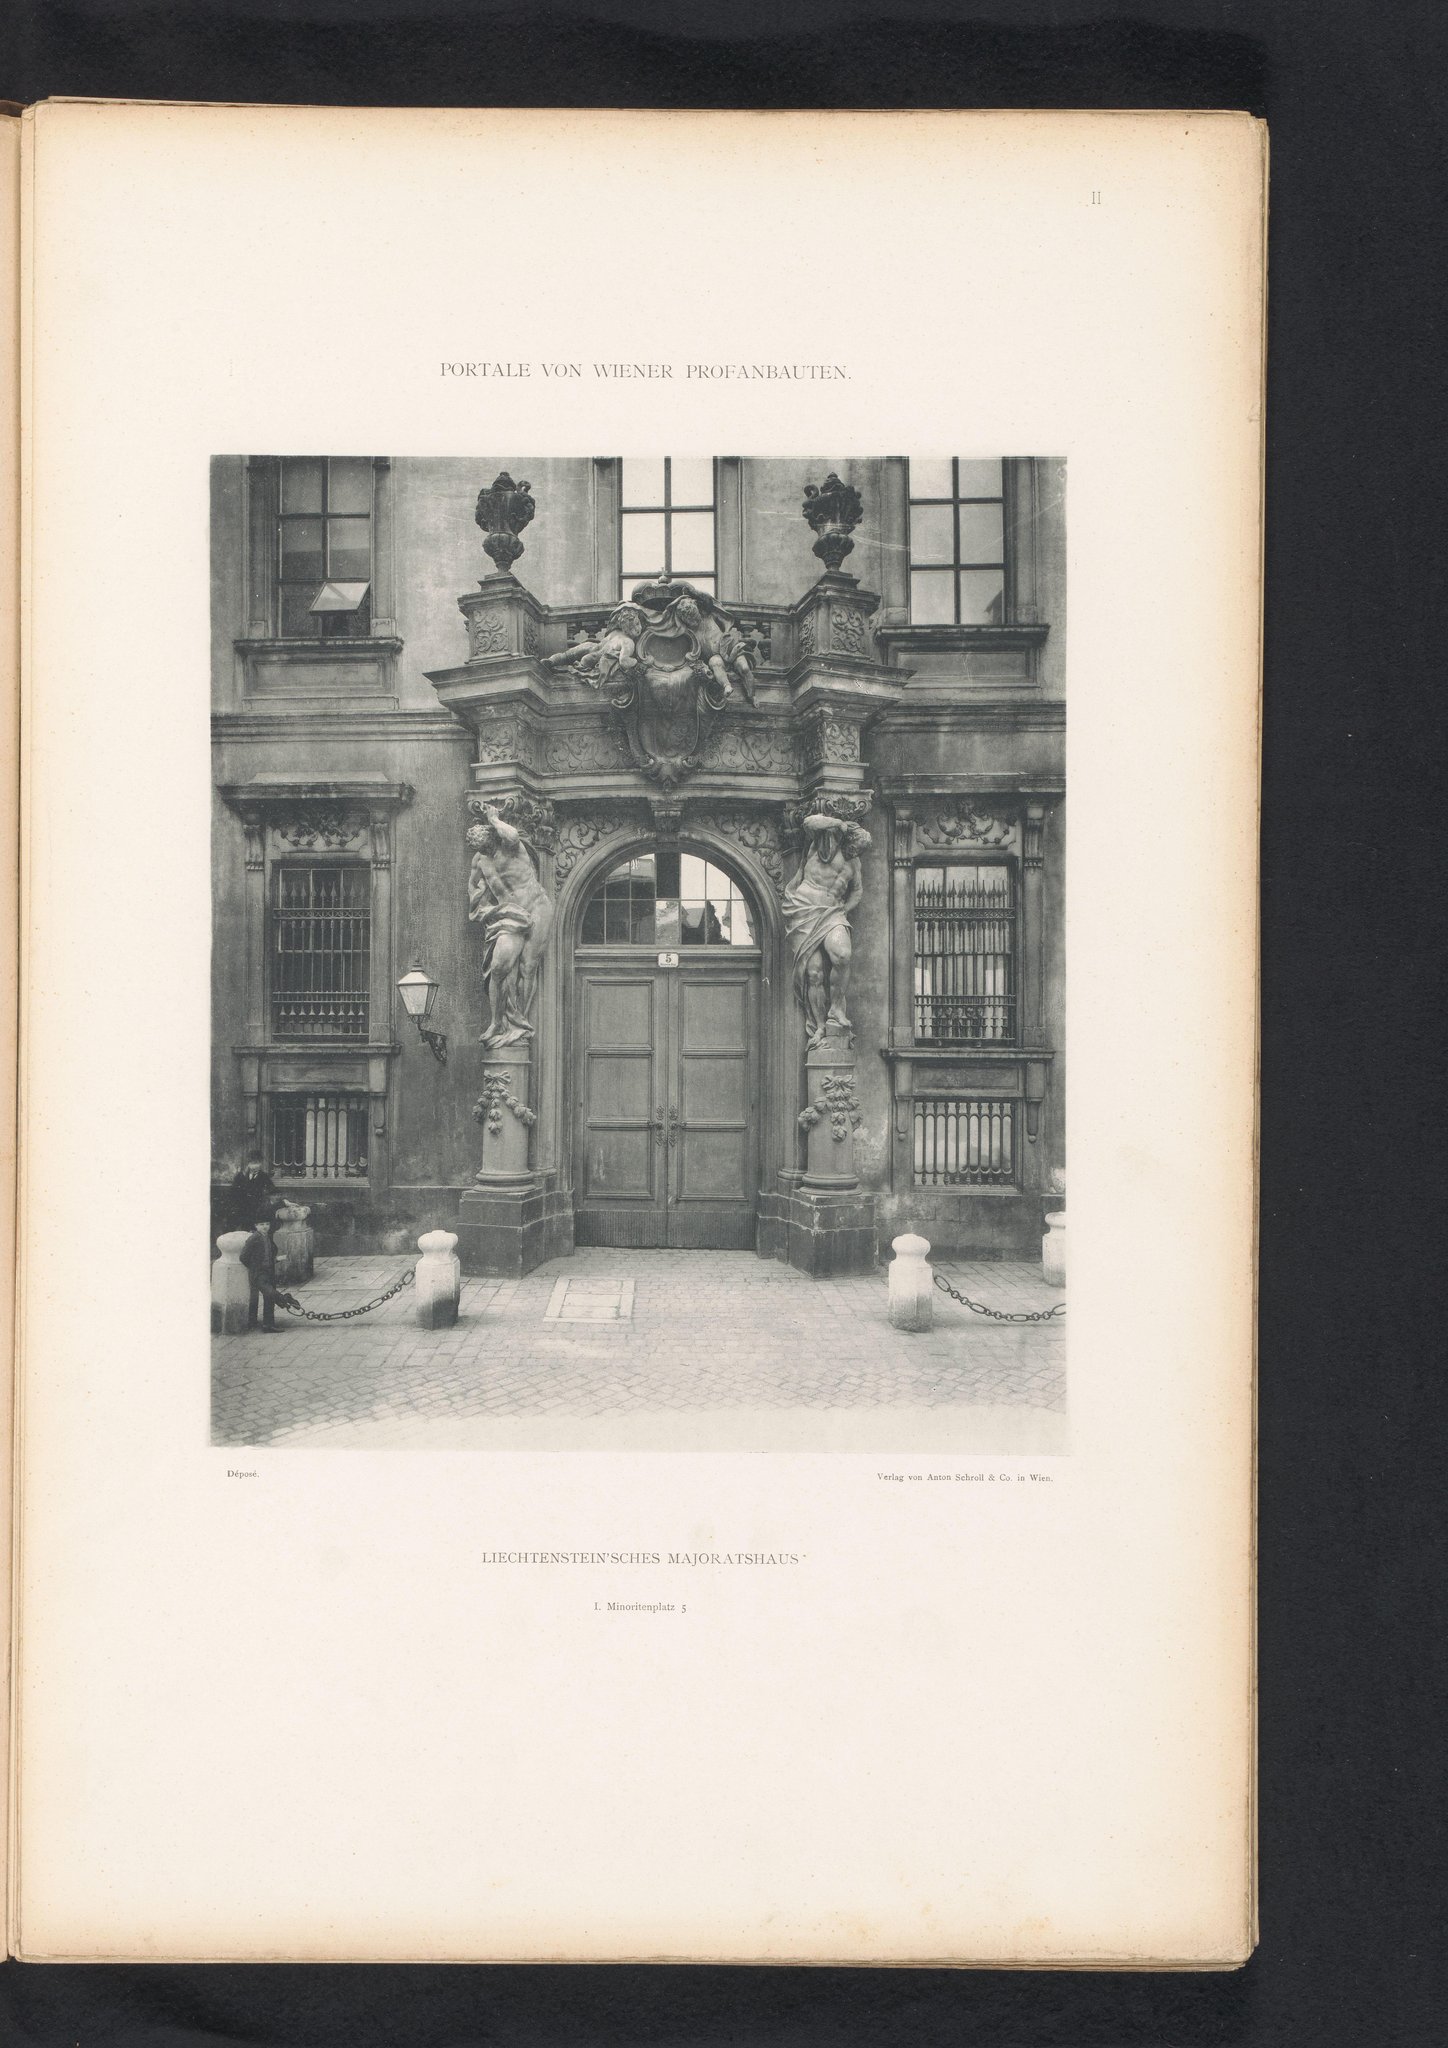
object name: page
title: Toegangsportaal van Stadtpalais Liechtenstein te Wenen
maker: Anonymous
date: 1884-1894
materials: paper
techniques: photograph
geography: austria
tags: gate, entrance, façade (of house or building)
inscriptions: number: ‘II’, inscription: ‘I. Minoritenplatz 5’